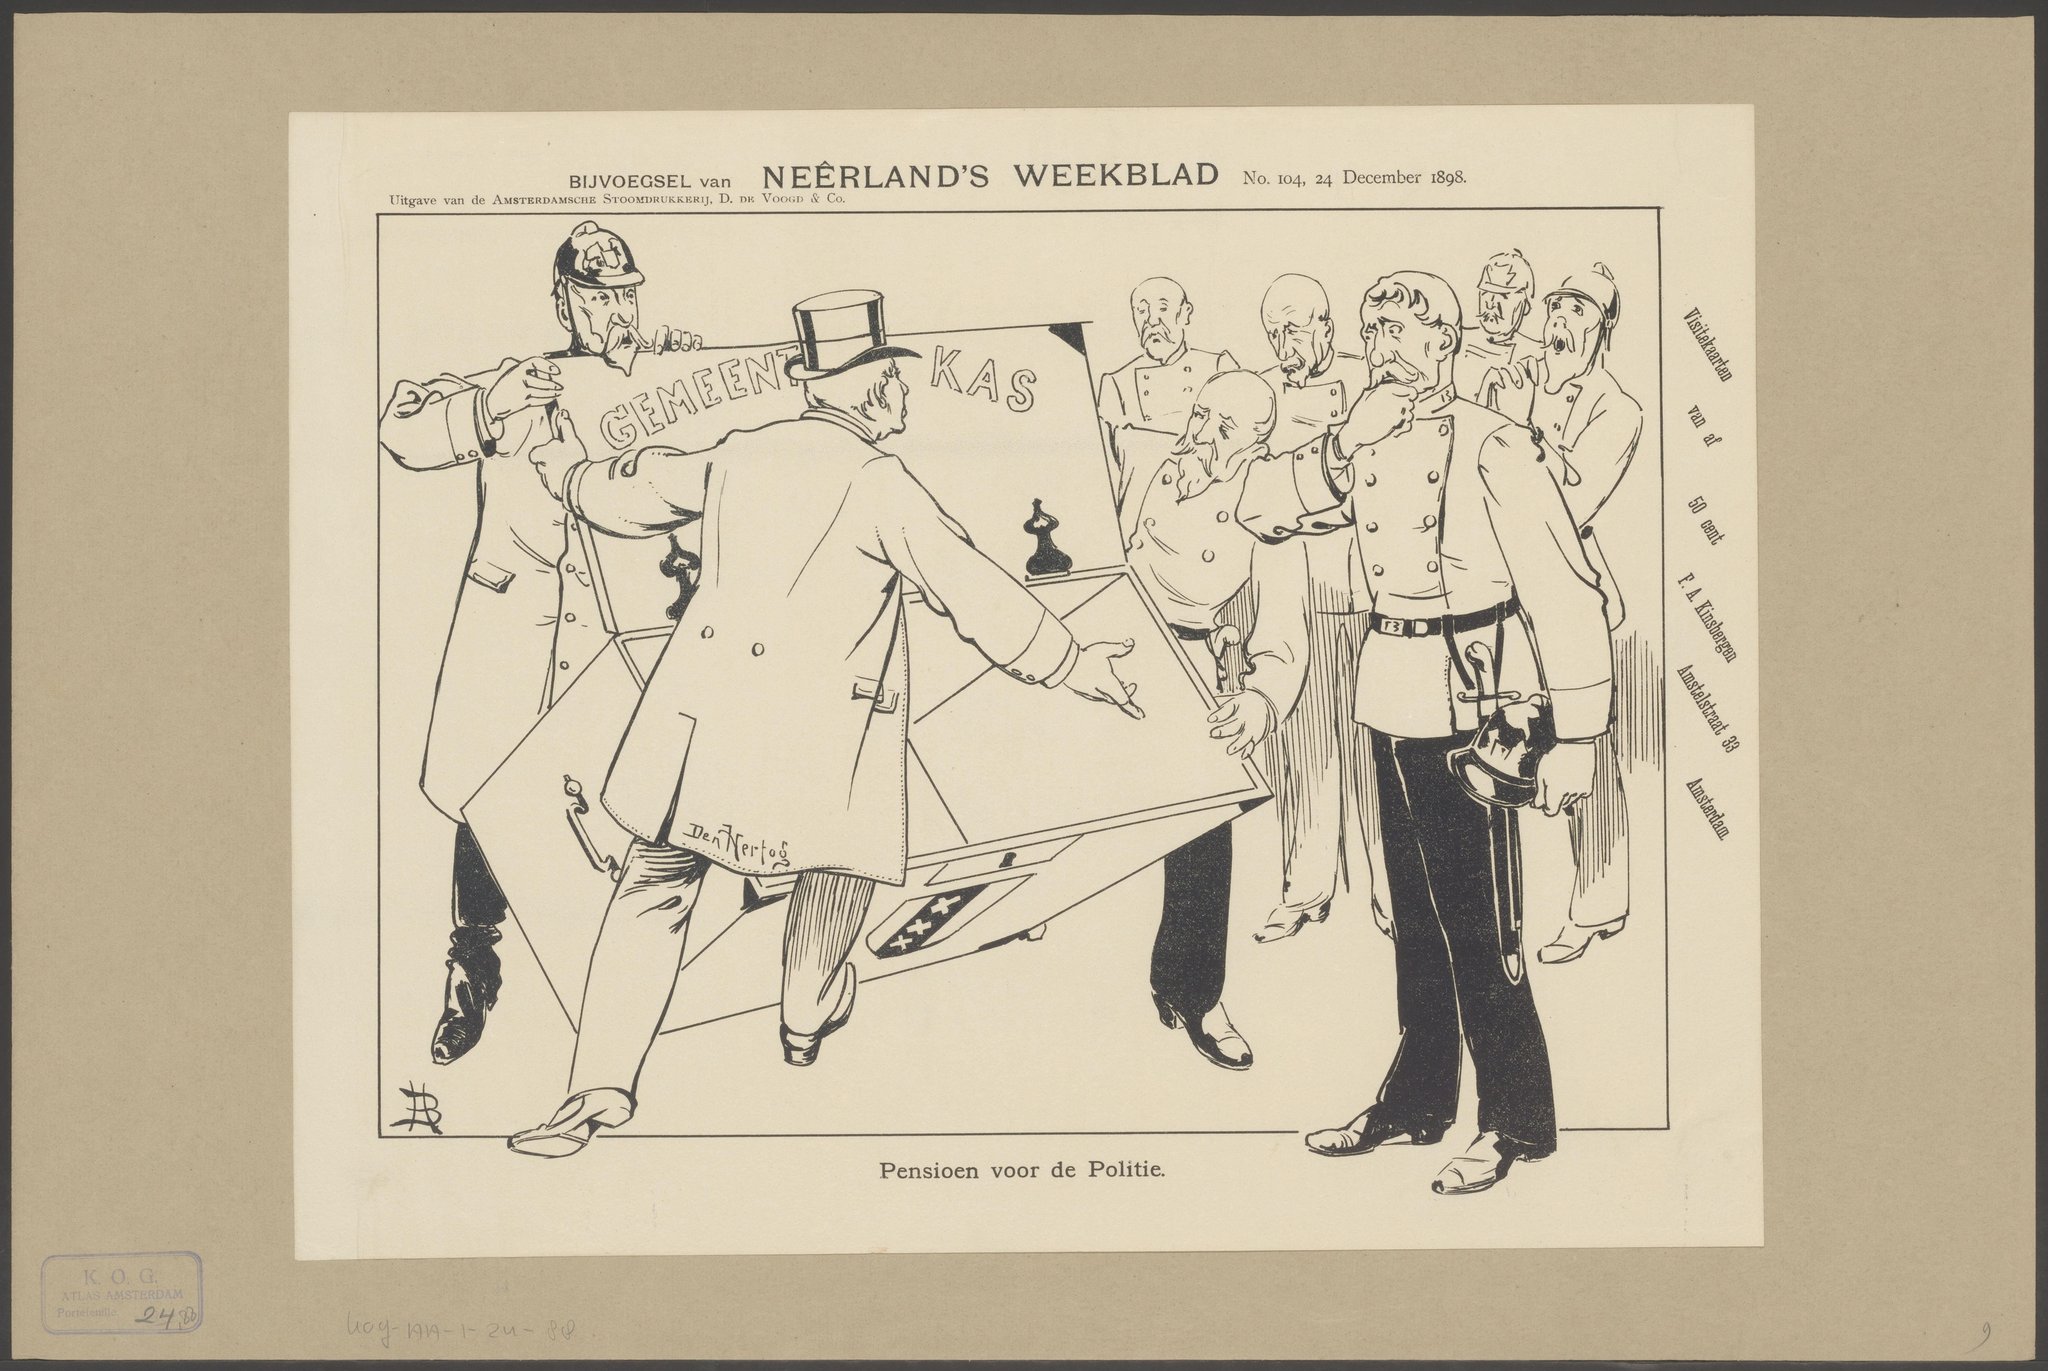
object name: cartoon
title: Pensioen van de Politie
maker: Anonymous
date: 1898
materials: paper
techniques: letterpress printing, lithograph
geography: amsterdam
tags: money-chest, treasure-chest, money-box, political caricatures and satires, police, amsterdam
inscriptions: collector's mark: Lugt 1641b, monogram: ‘AB (?)’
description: Gepubliceerd als bijvoegsel van 'Neêrland's Weekblad', 24 december 1898.